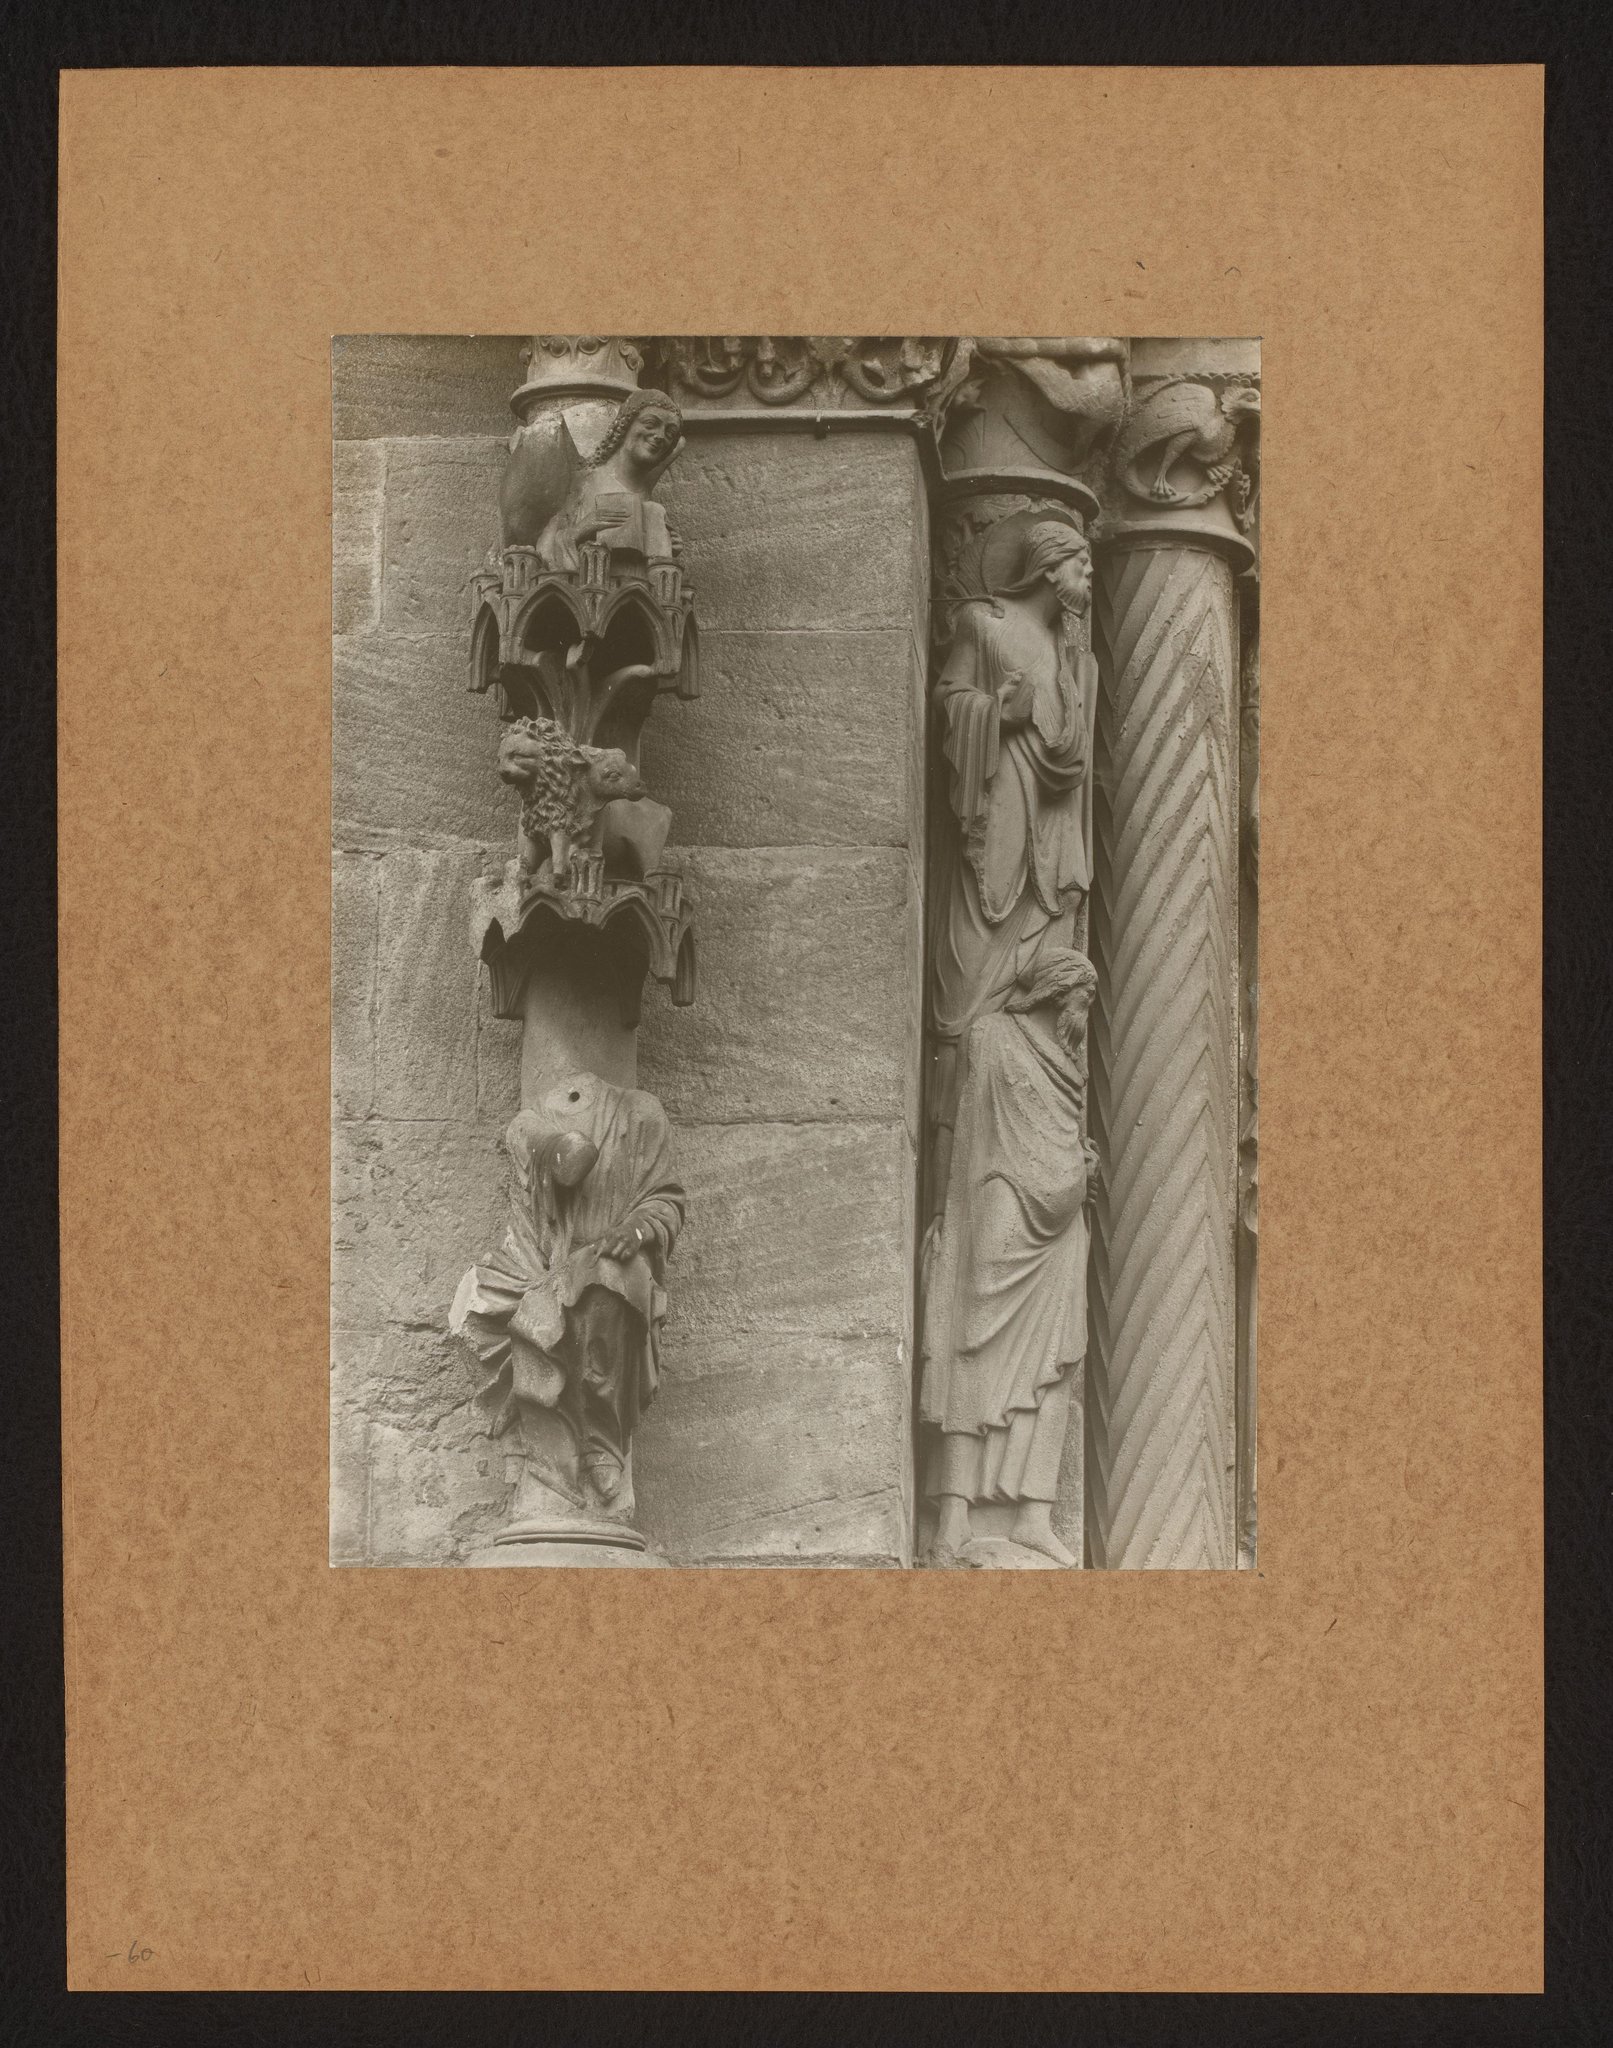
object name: photograph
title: Adamspforte, Fürstentor, Evang. Säule u. Gew. Statuen l.l.v.N.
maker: Anonymous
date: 1900-1920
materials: paper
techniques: gelatin silver print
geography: bamberg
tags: church (exterior)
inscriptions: number: ‘61’